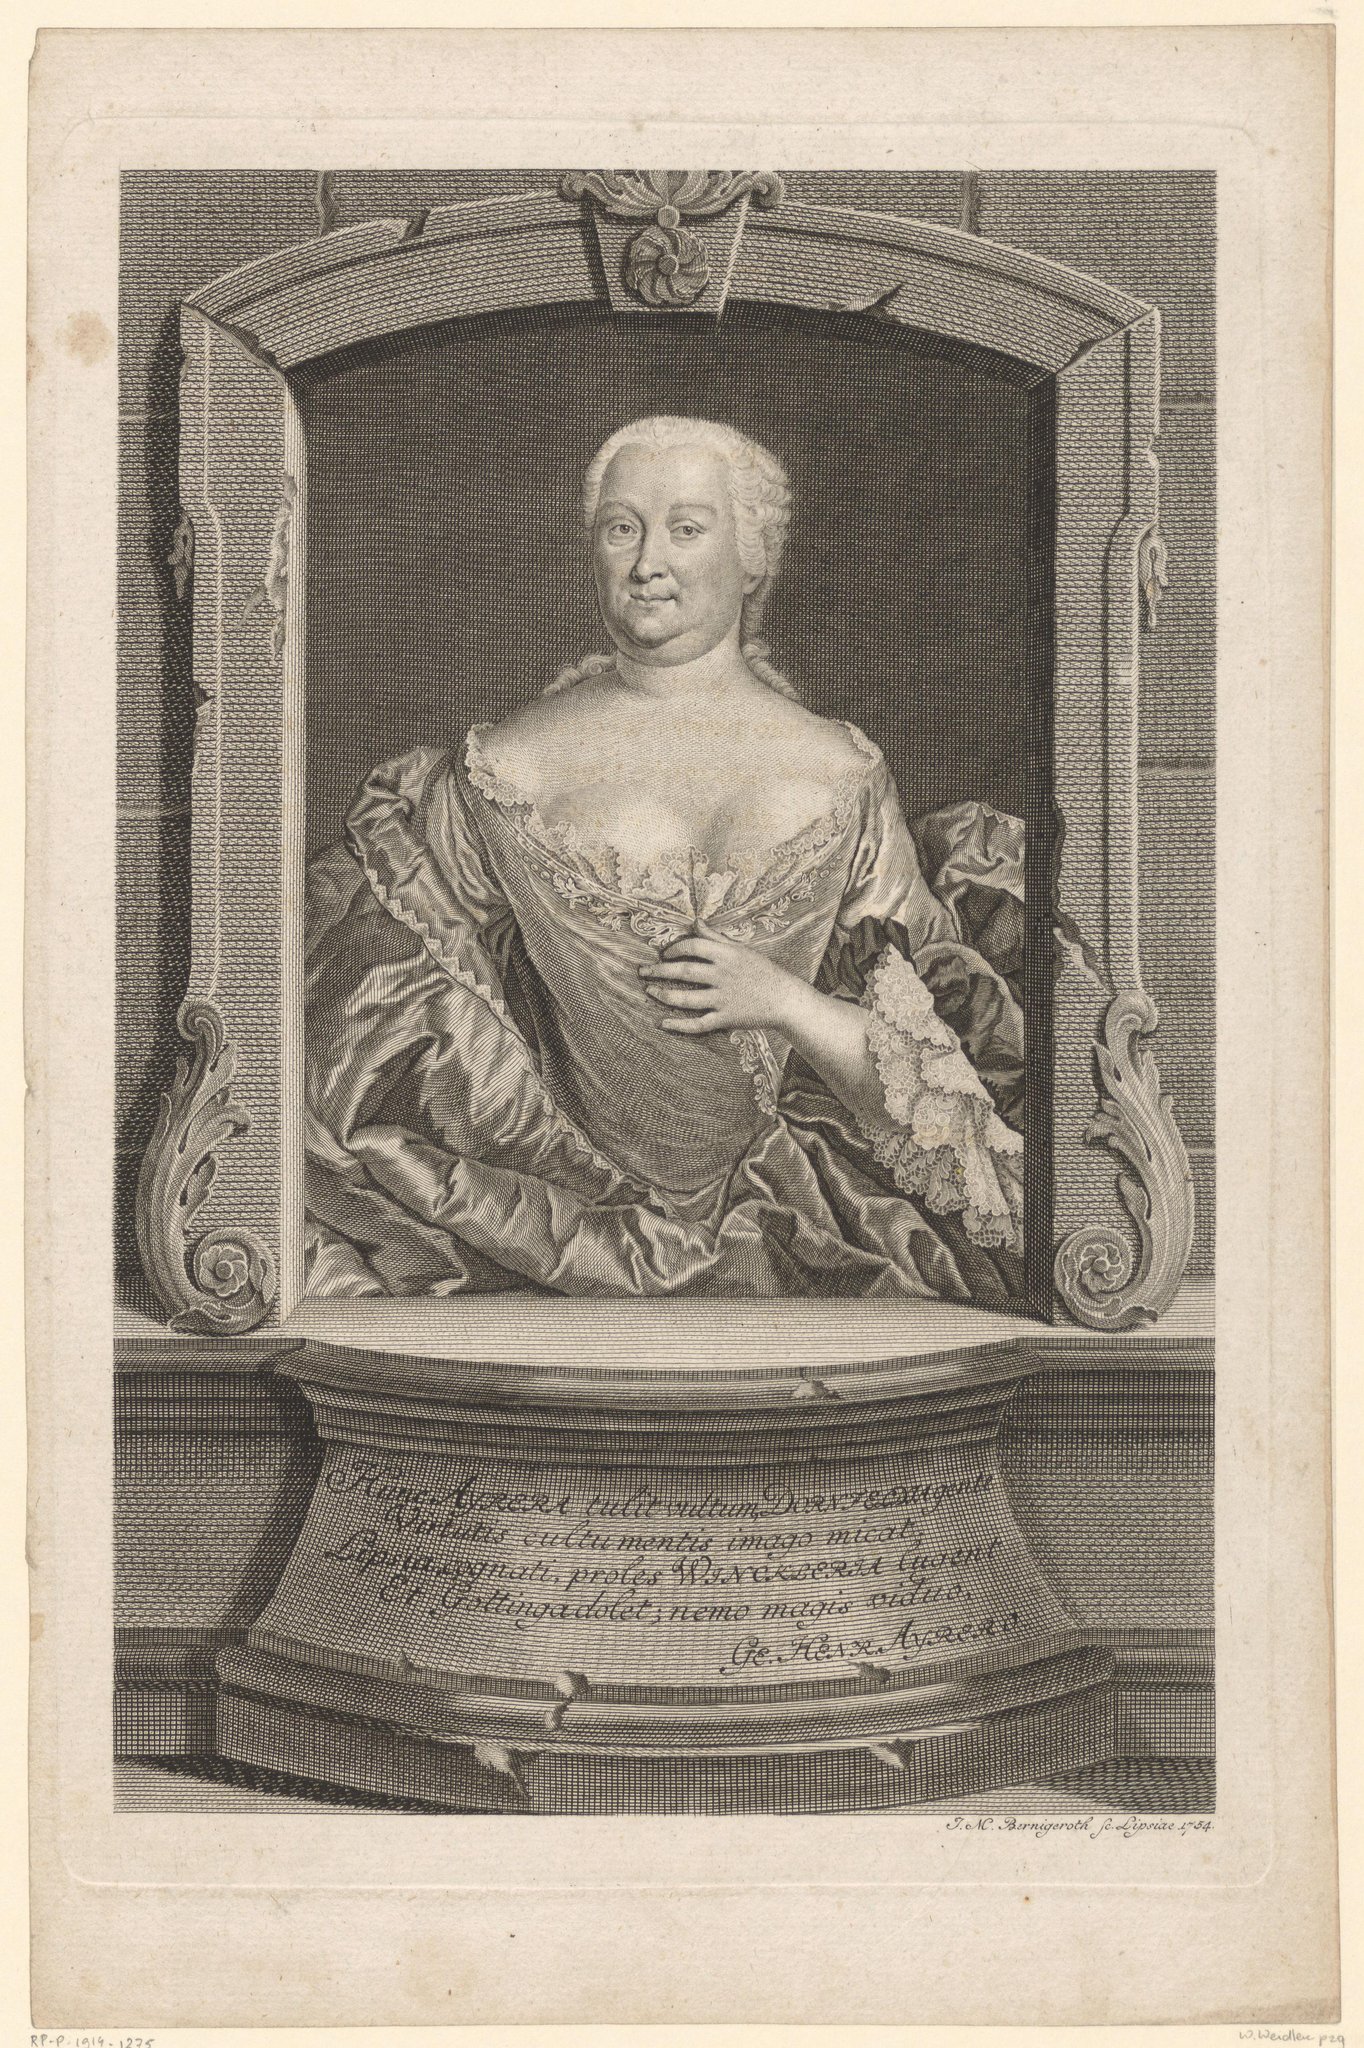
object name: print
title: Portret van Johanna Maria Ayrer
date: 1754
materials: paper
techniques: engraving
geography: leipzig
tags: historical persons - bb - woman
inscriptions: collector's mark: Lugt 2228